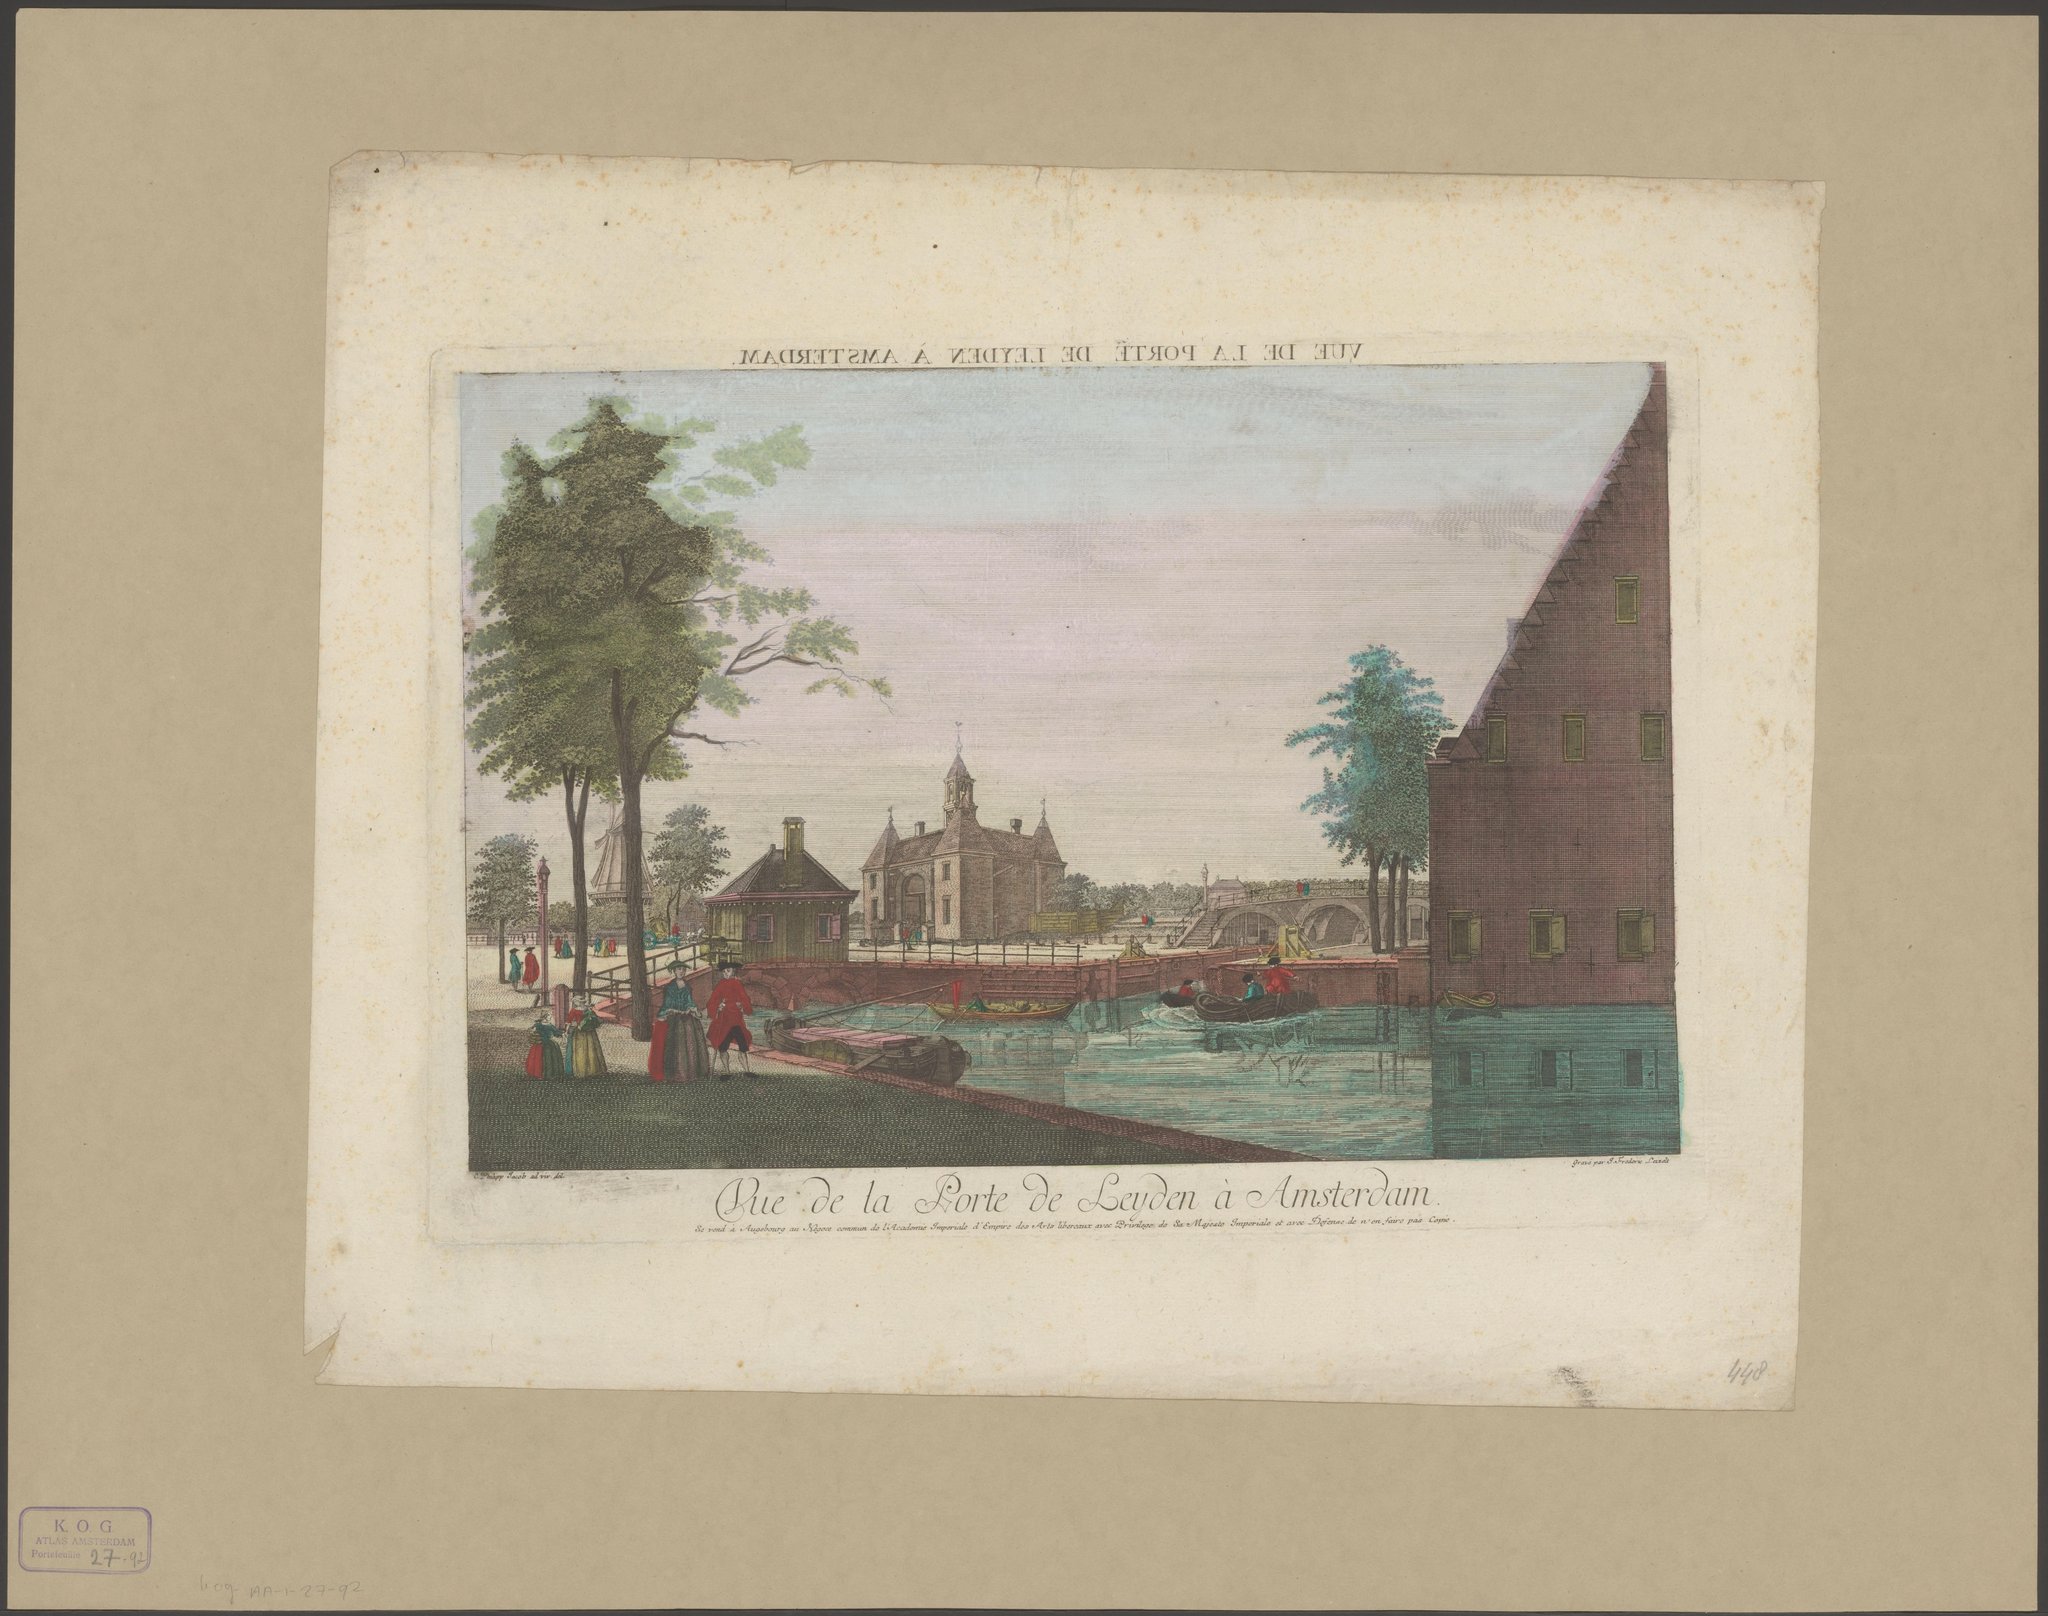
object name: print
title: Gezicht op de Leidsepoort te Amsterdam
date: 1755-1779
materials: paper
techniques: etching, hand coloring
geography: amsterdam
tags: bridge in city across river, canal, etc. (+ city(-scape) with figures, staffage), rowing-boat, canoe, etc., gate, entrance, windmill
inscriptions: collector's mark: Lugt 1641b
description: Onderwerpsrubriek binnen de Atlas Amsterdam: B. Poorten, verzamelbladen, F. Leidsepoort.